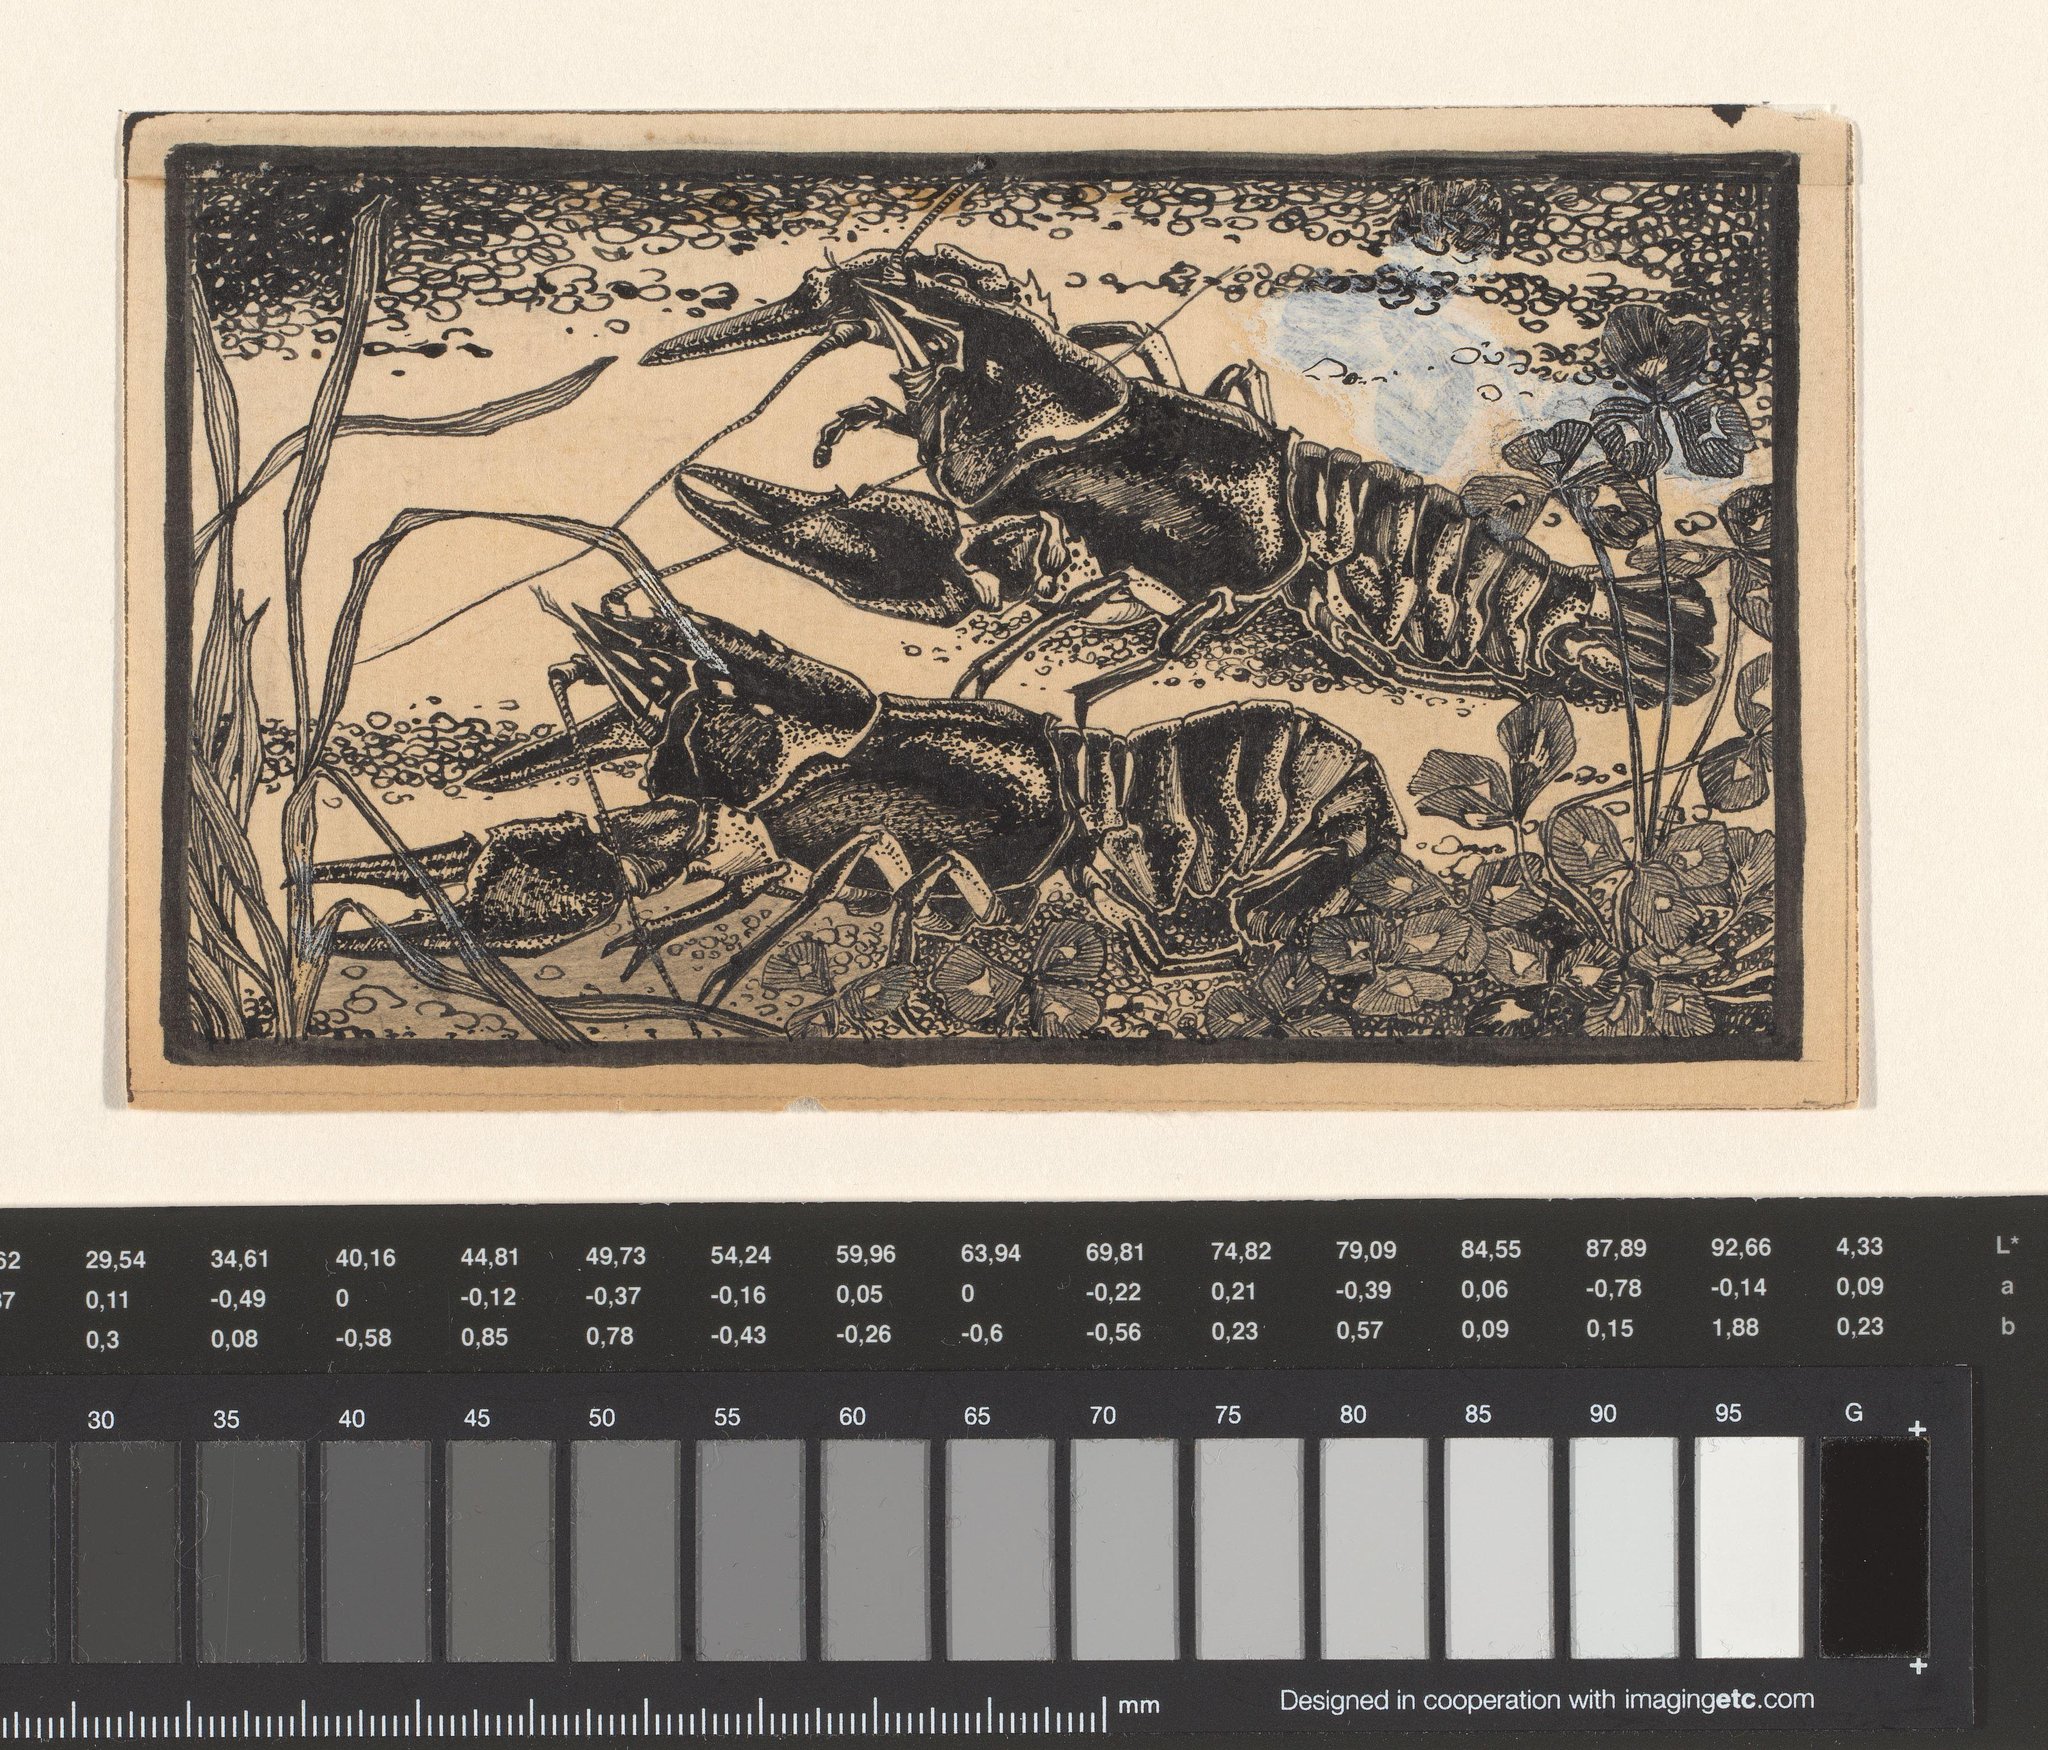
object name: drawing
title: Twee kreeften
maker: julie de graag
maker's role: draughtsman, print maker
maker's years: 1877-1924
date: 1887-1924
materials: paint, ink, paper, pencil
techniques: brush, pen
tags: flowers, crustaceans: lobster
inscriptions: number: ‘49’